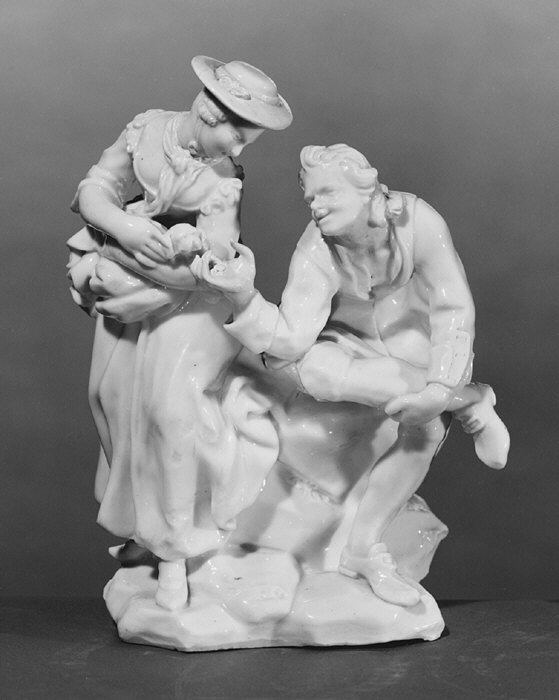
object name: group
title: Couple with dog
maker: capodimonte porcelain manufactory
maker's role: manufactory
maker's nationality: italian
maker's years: 1740-1759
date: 1750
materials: soft paste porcelain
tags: couples,dogs